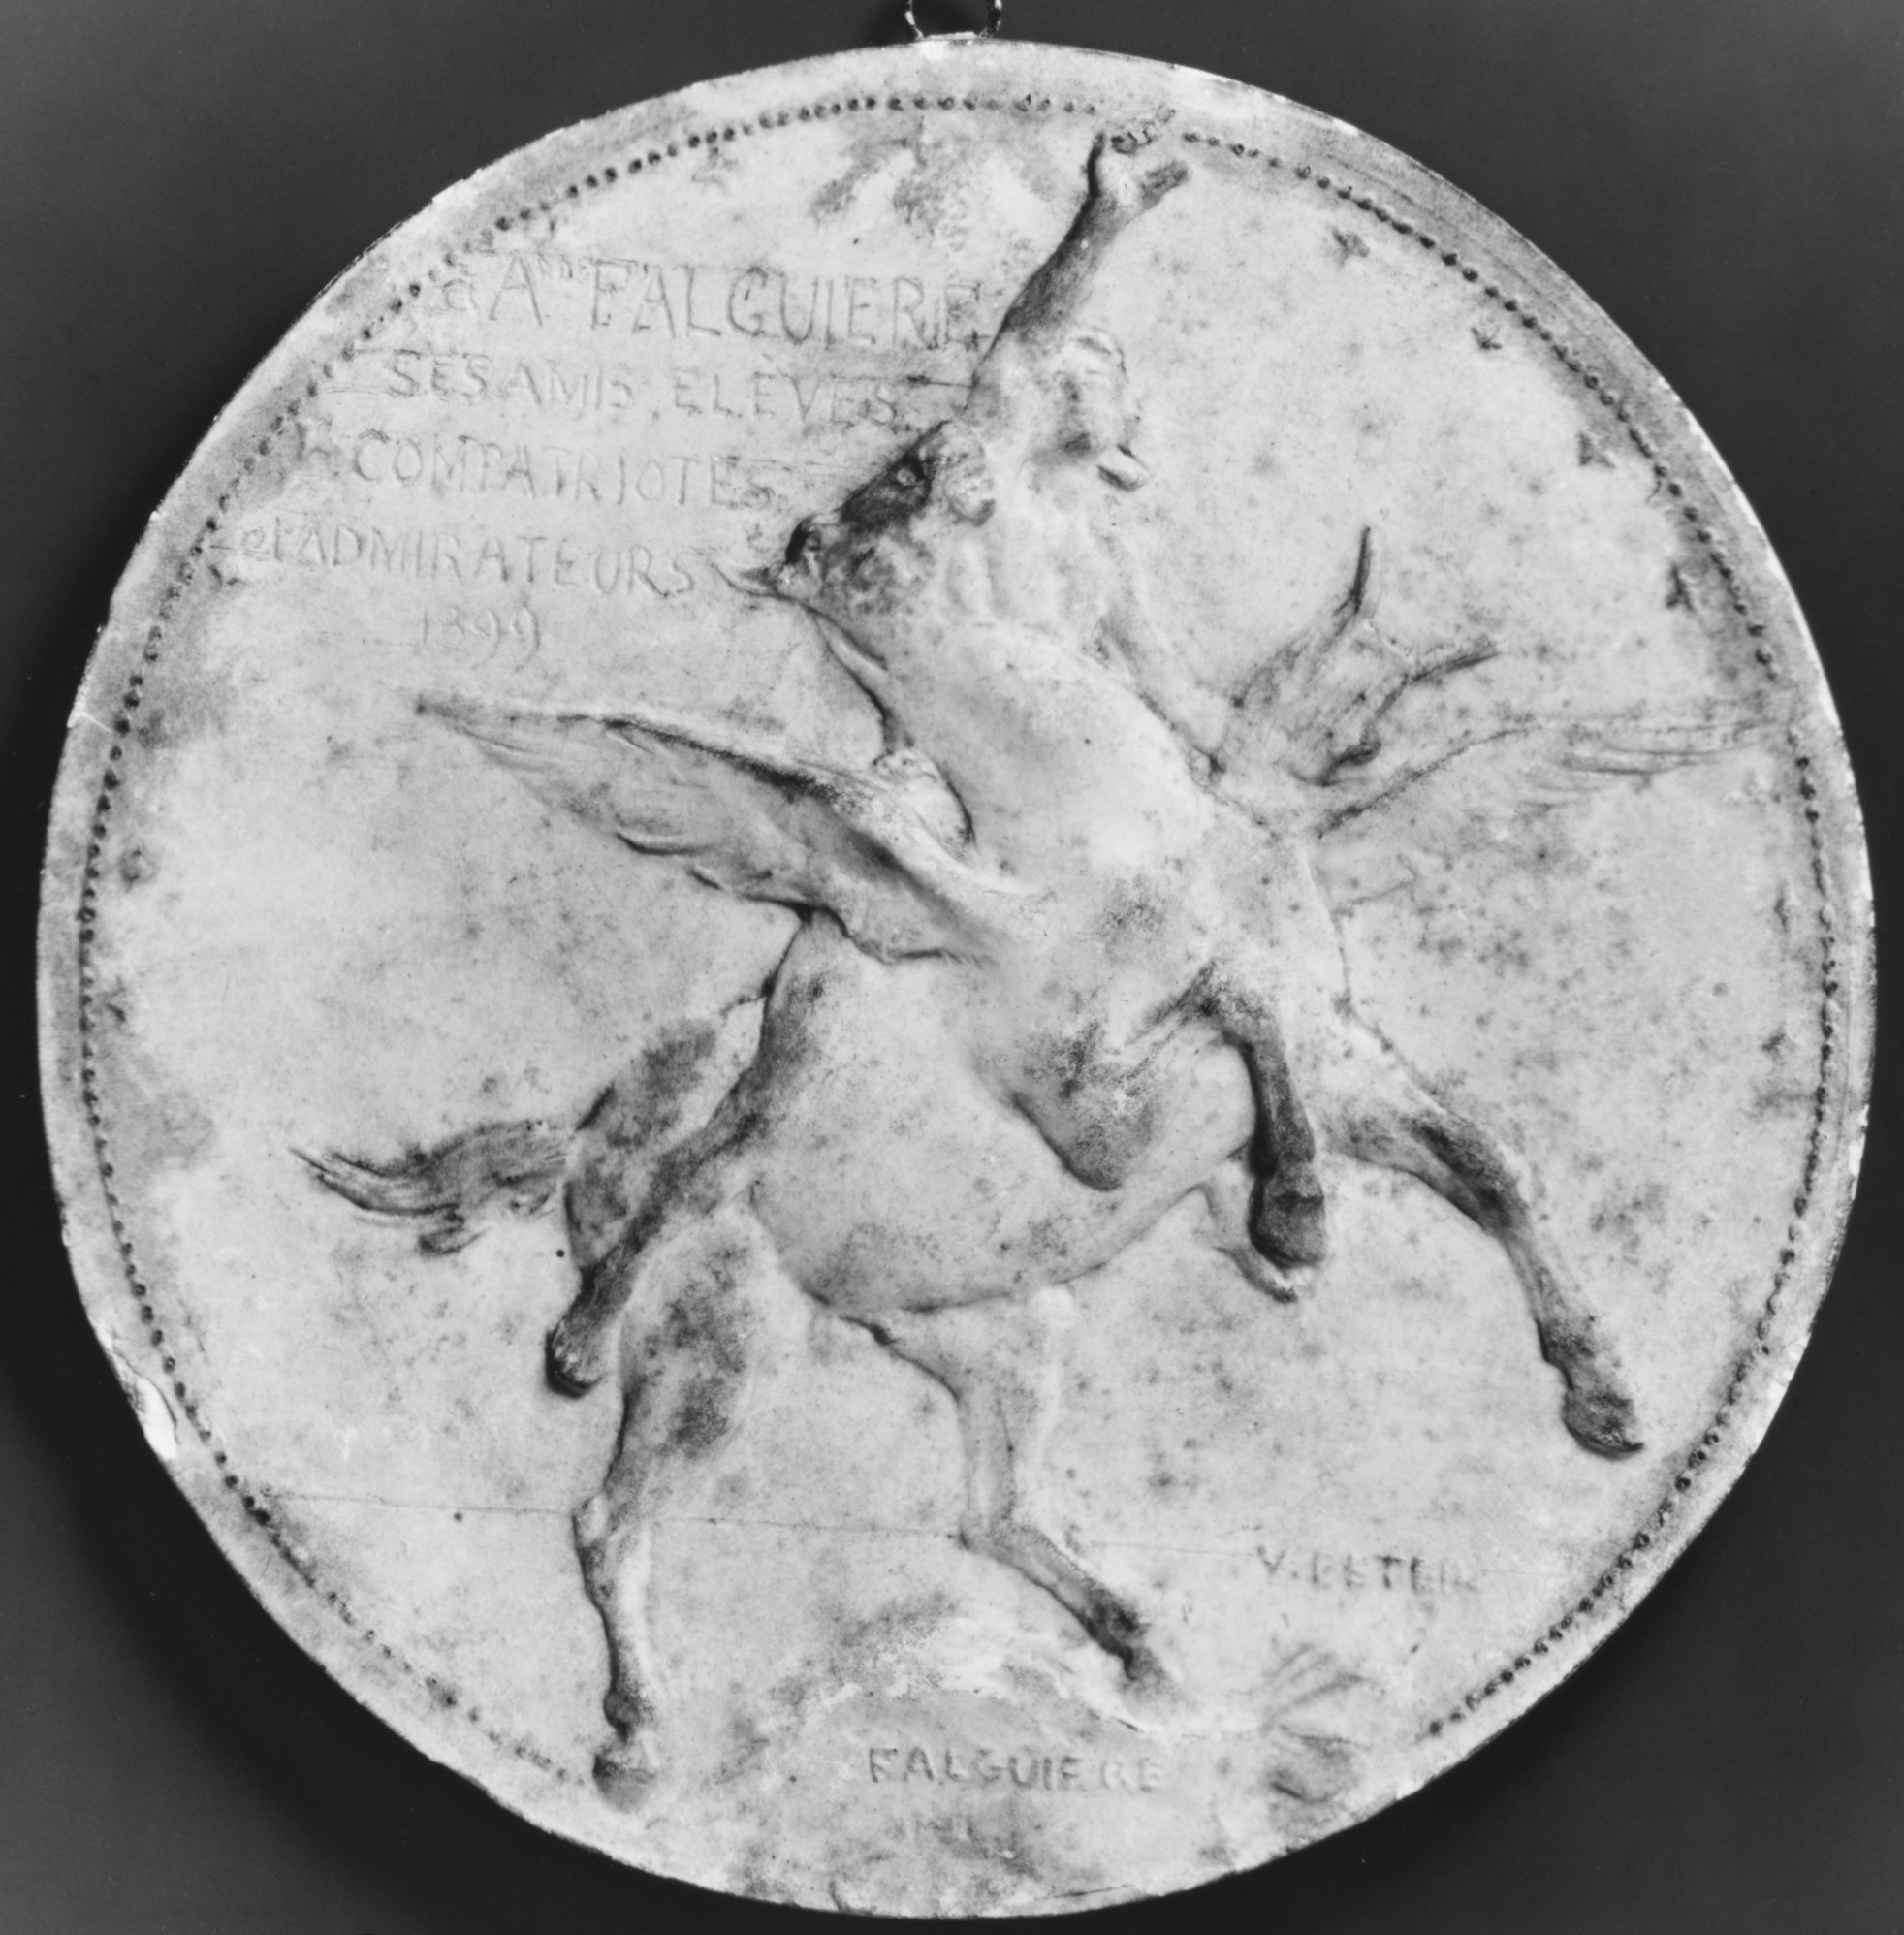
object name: medal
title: Alexandre Falguière (1831–1900)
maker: victor peter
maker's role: artist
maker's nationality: french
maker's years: 1840-1918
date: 1899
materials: plaster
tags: pegasus